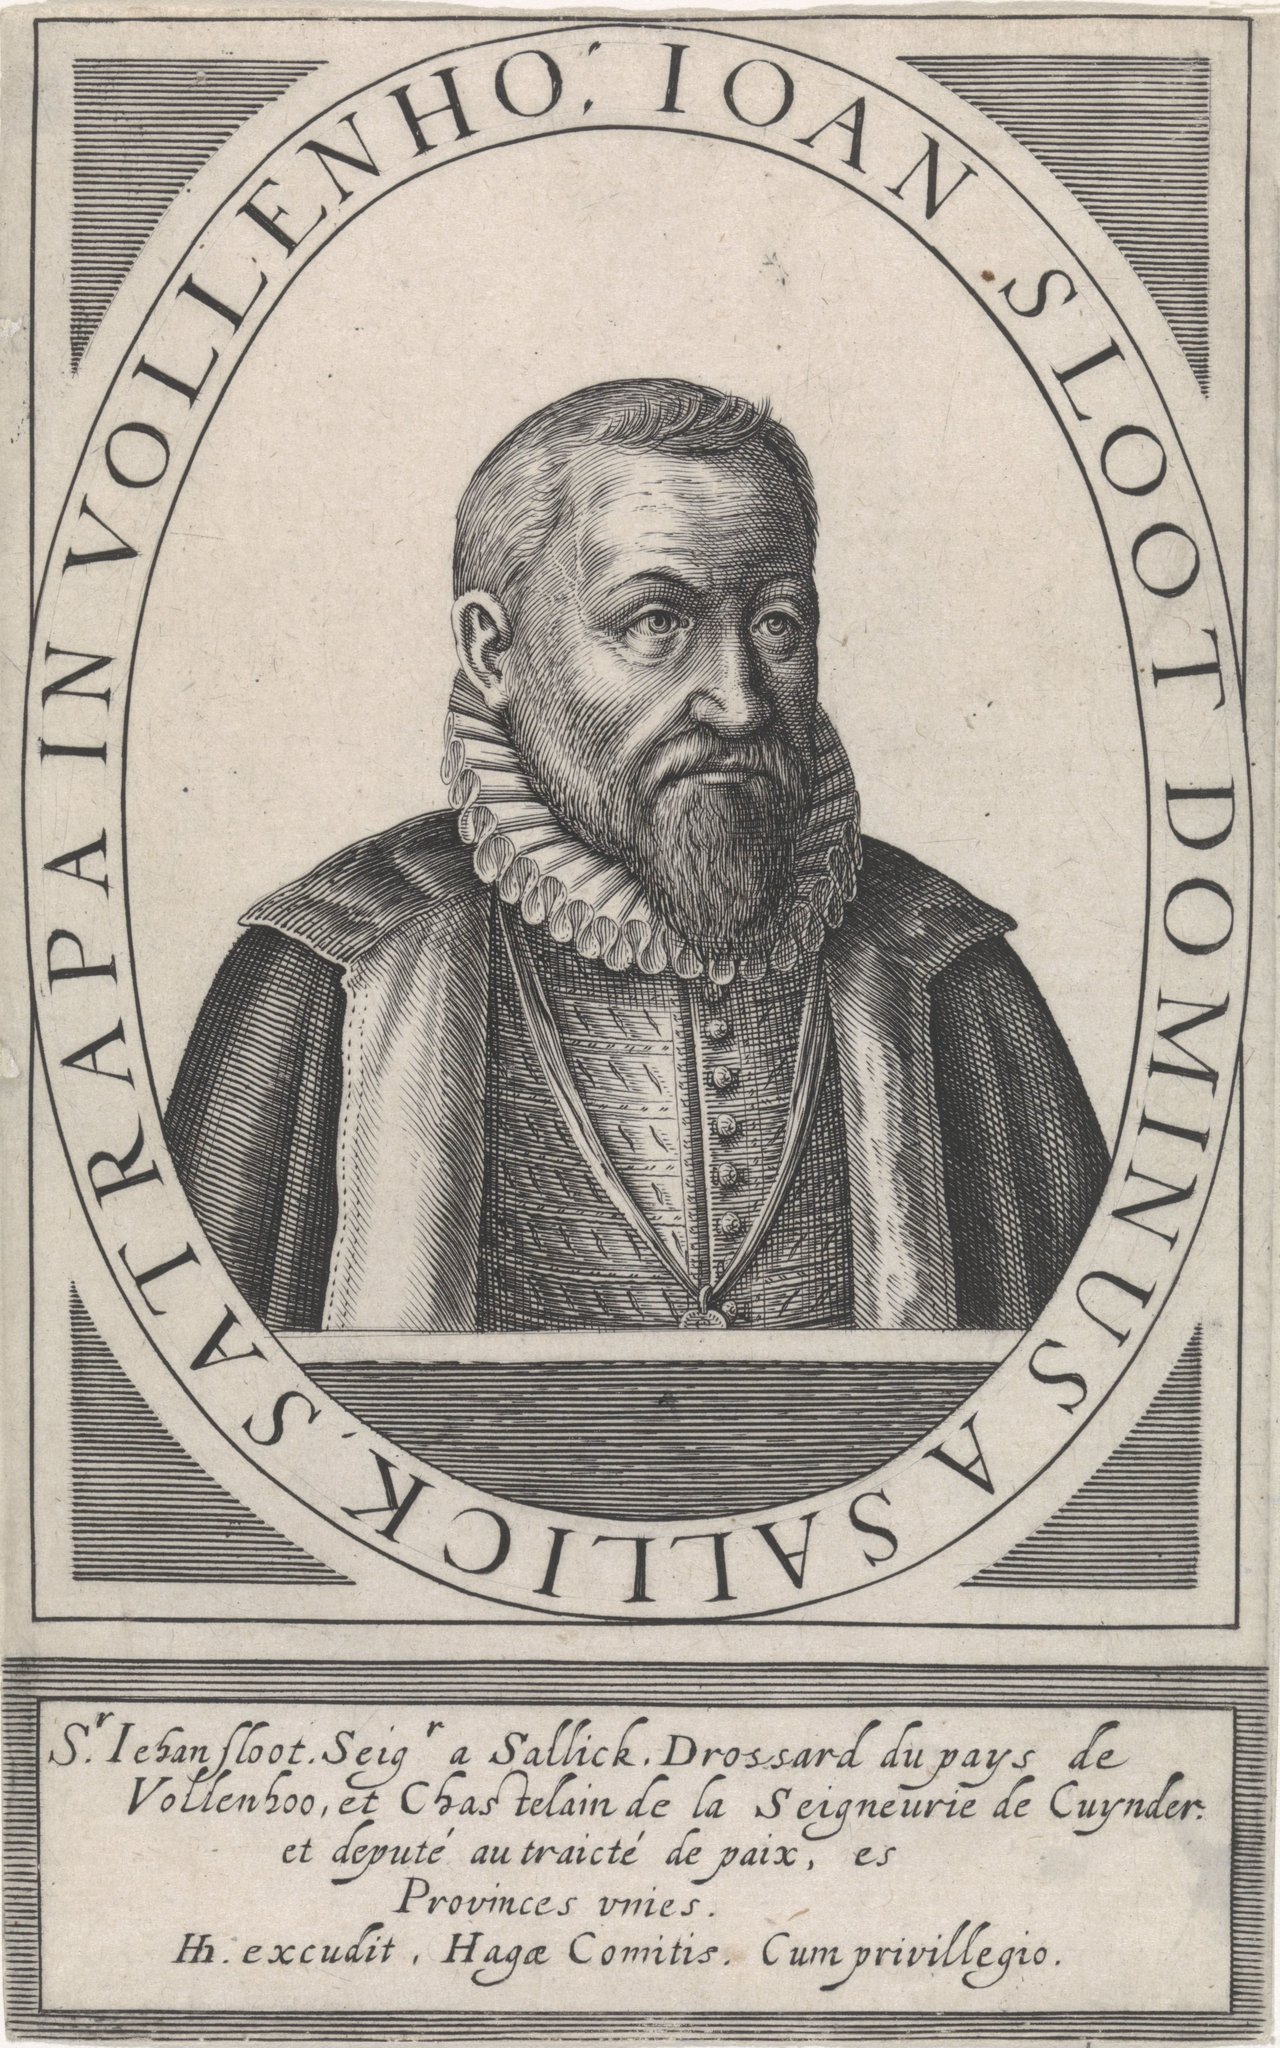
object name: print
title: Portret van Jan Sloot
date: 1608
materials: paper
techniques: engraving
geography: the hague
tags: jan sloot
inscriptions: collector's mark: Lugt 2228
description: Buste naar rechts van Jan Sloot, in een ovale omlijsting, waarop een randschrift met zijn naam en titel in het Latijn. Onder het portret vier regels in het Frans. Prent uit een serie van veertig portretten van vredestichters in de Nederlanden.